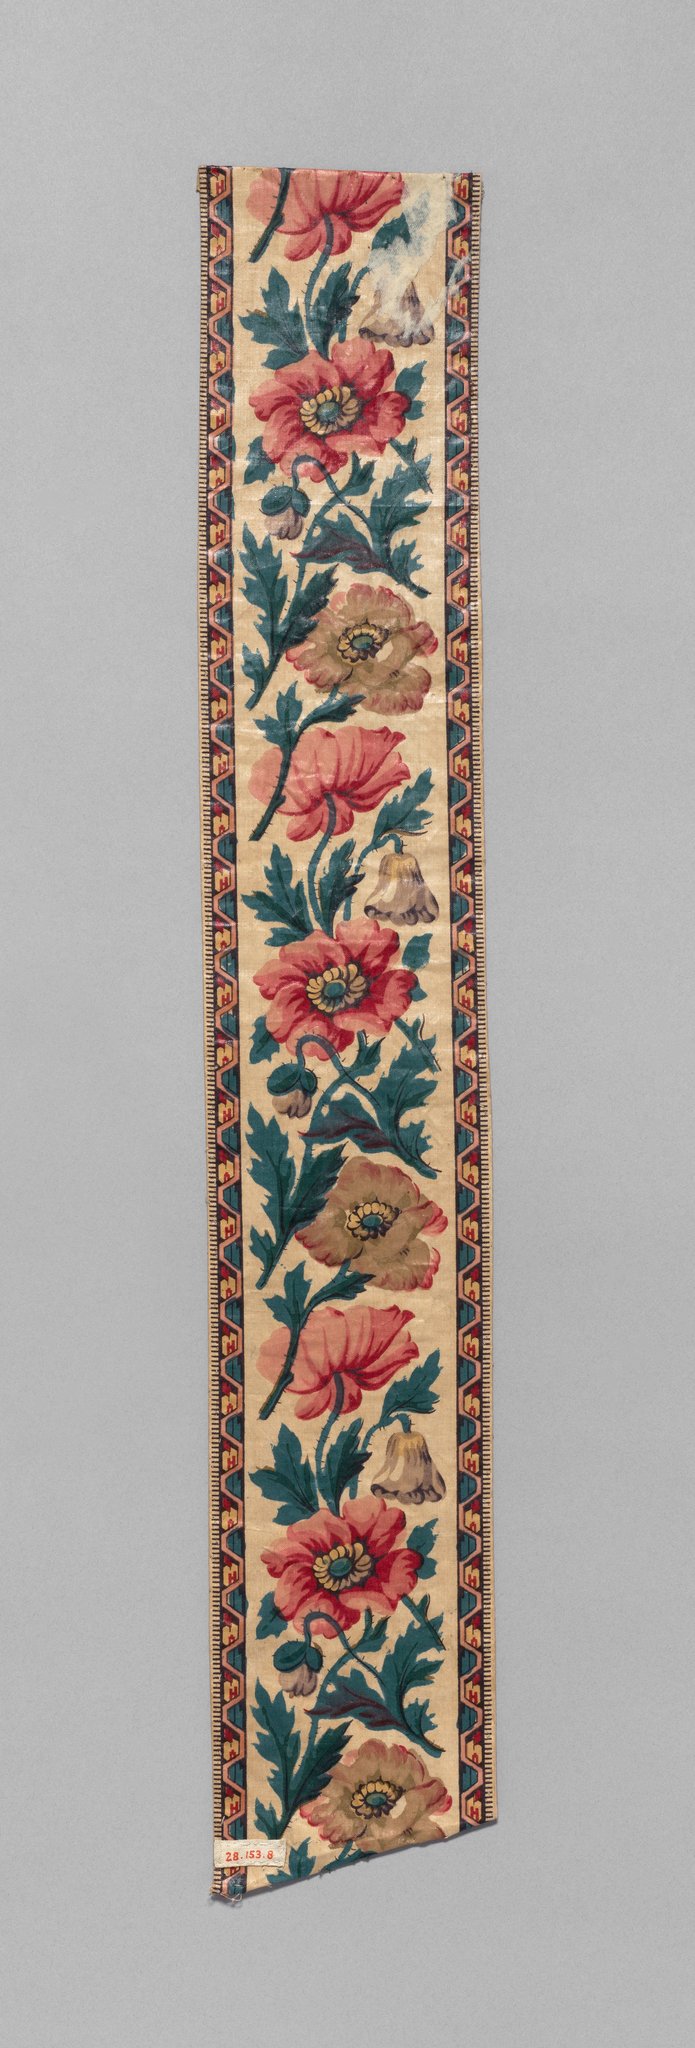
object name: border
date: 1840-1850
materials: cotton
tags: flowers